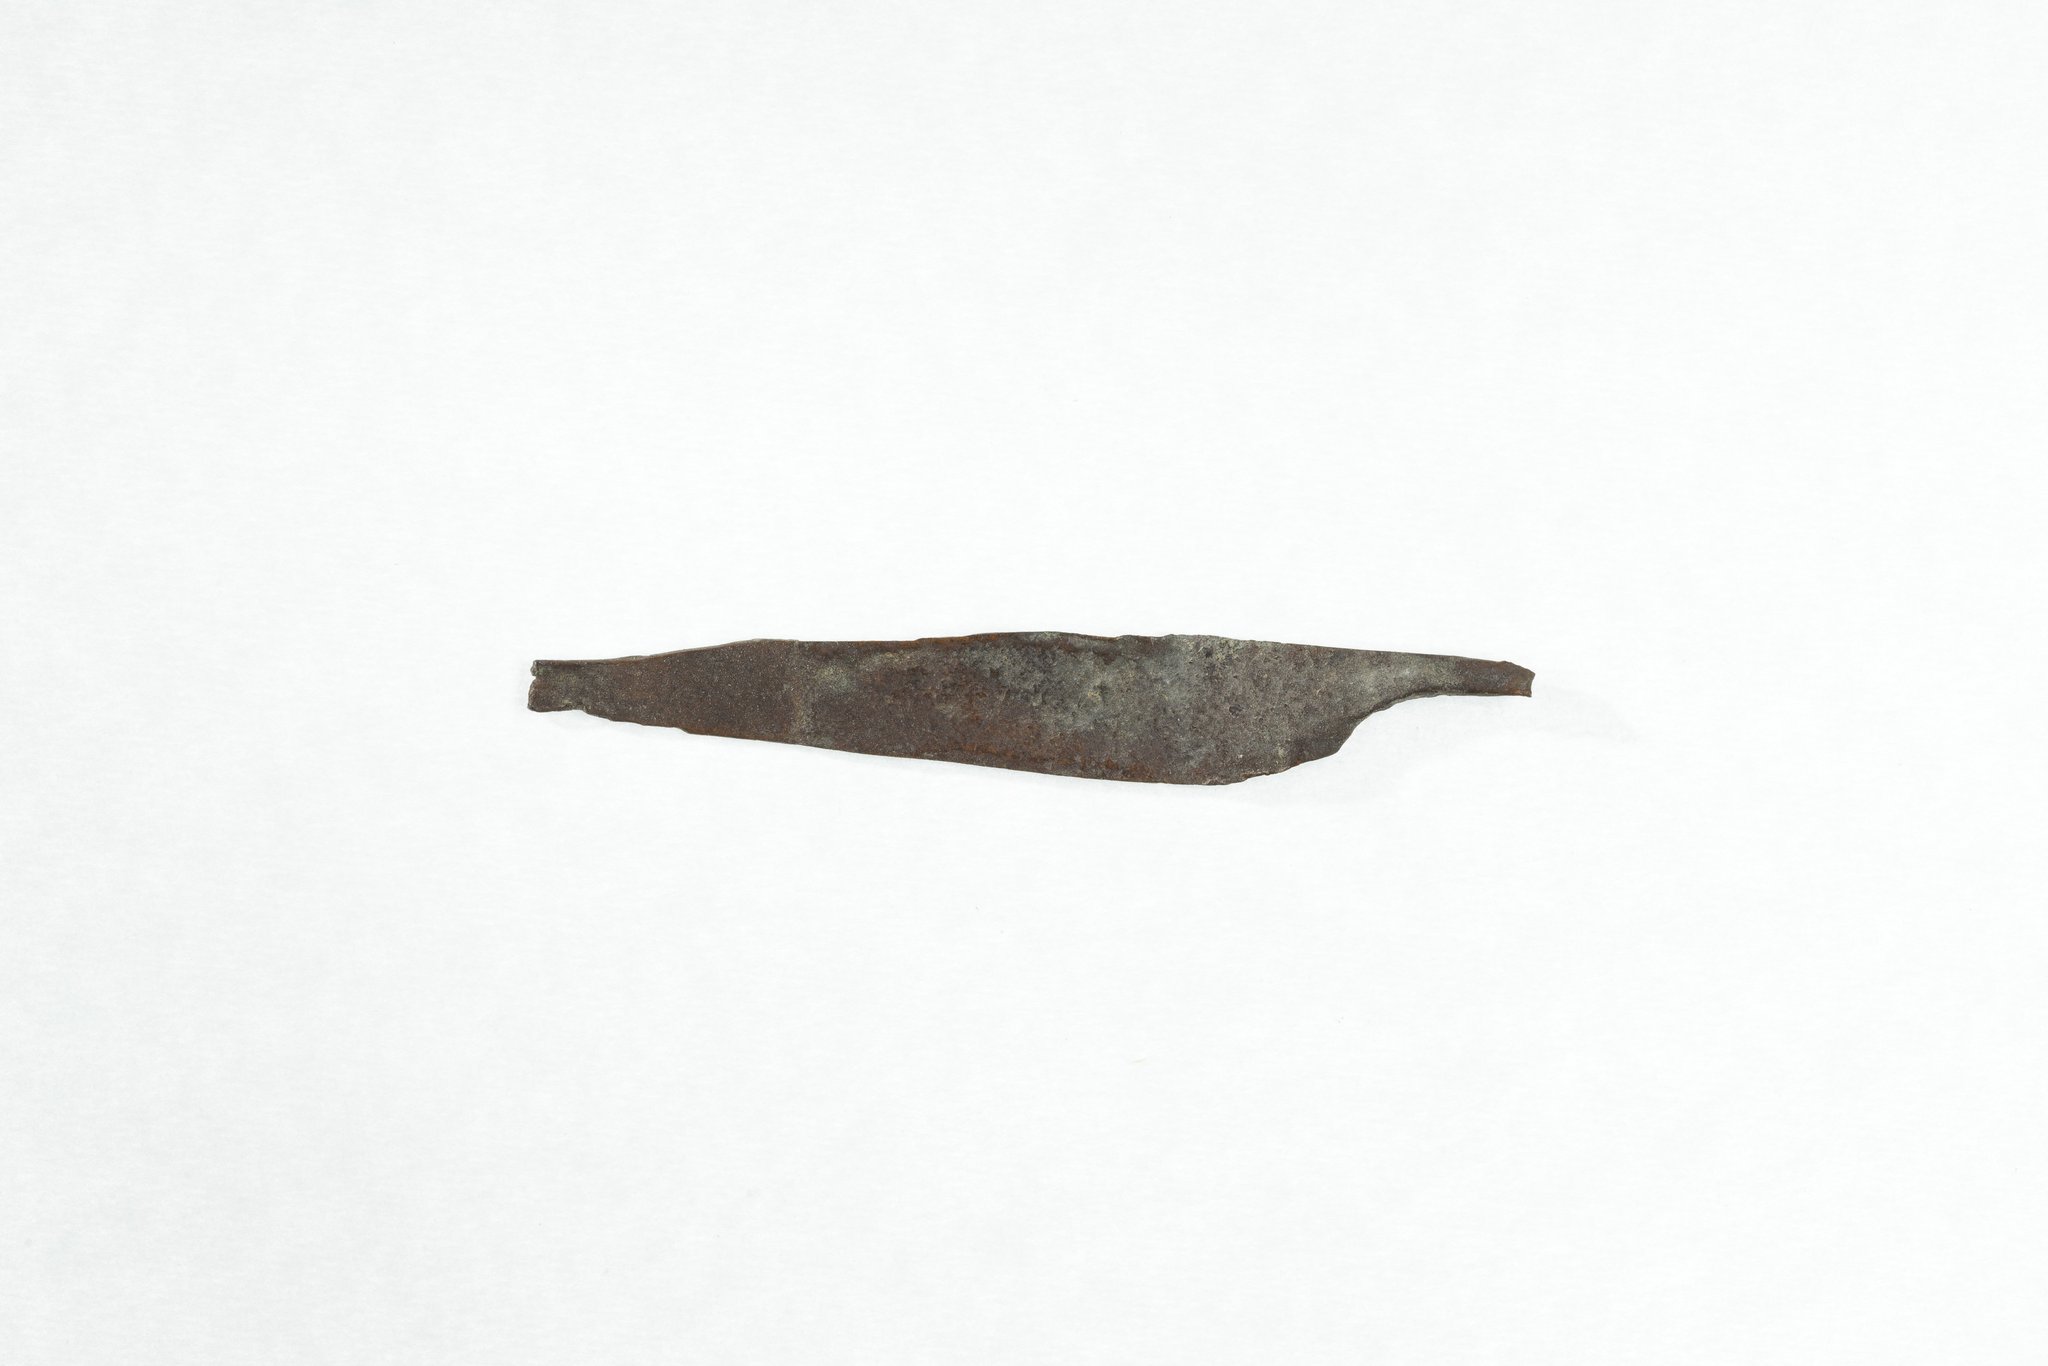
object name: saw, model, tool, senenmut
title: Blade for a Model Saw from a Foundation Deposit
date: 1479-1458 BCE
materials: bronze, copper alloy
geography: egypt